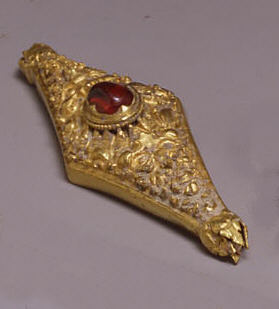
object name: clasp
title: Sacred Thread Clasp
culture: indonesian, javanese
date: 701-933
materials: gold